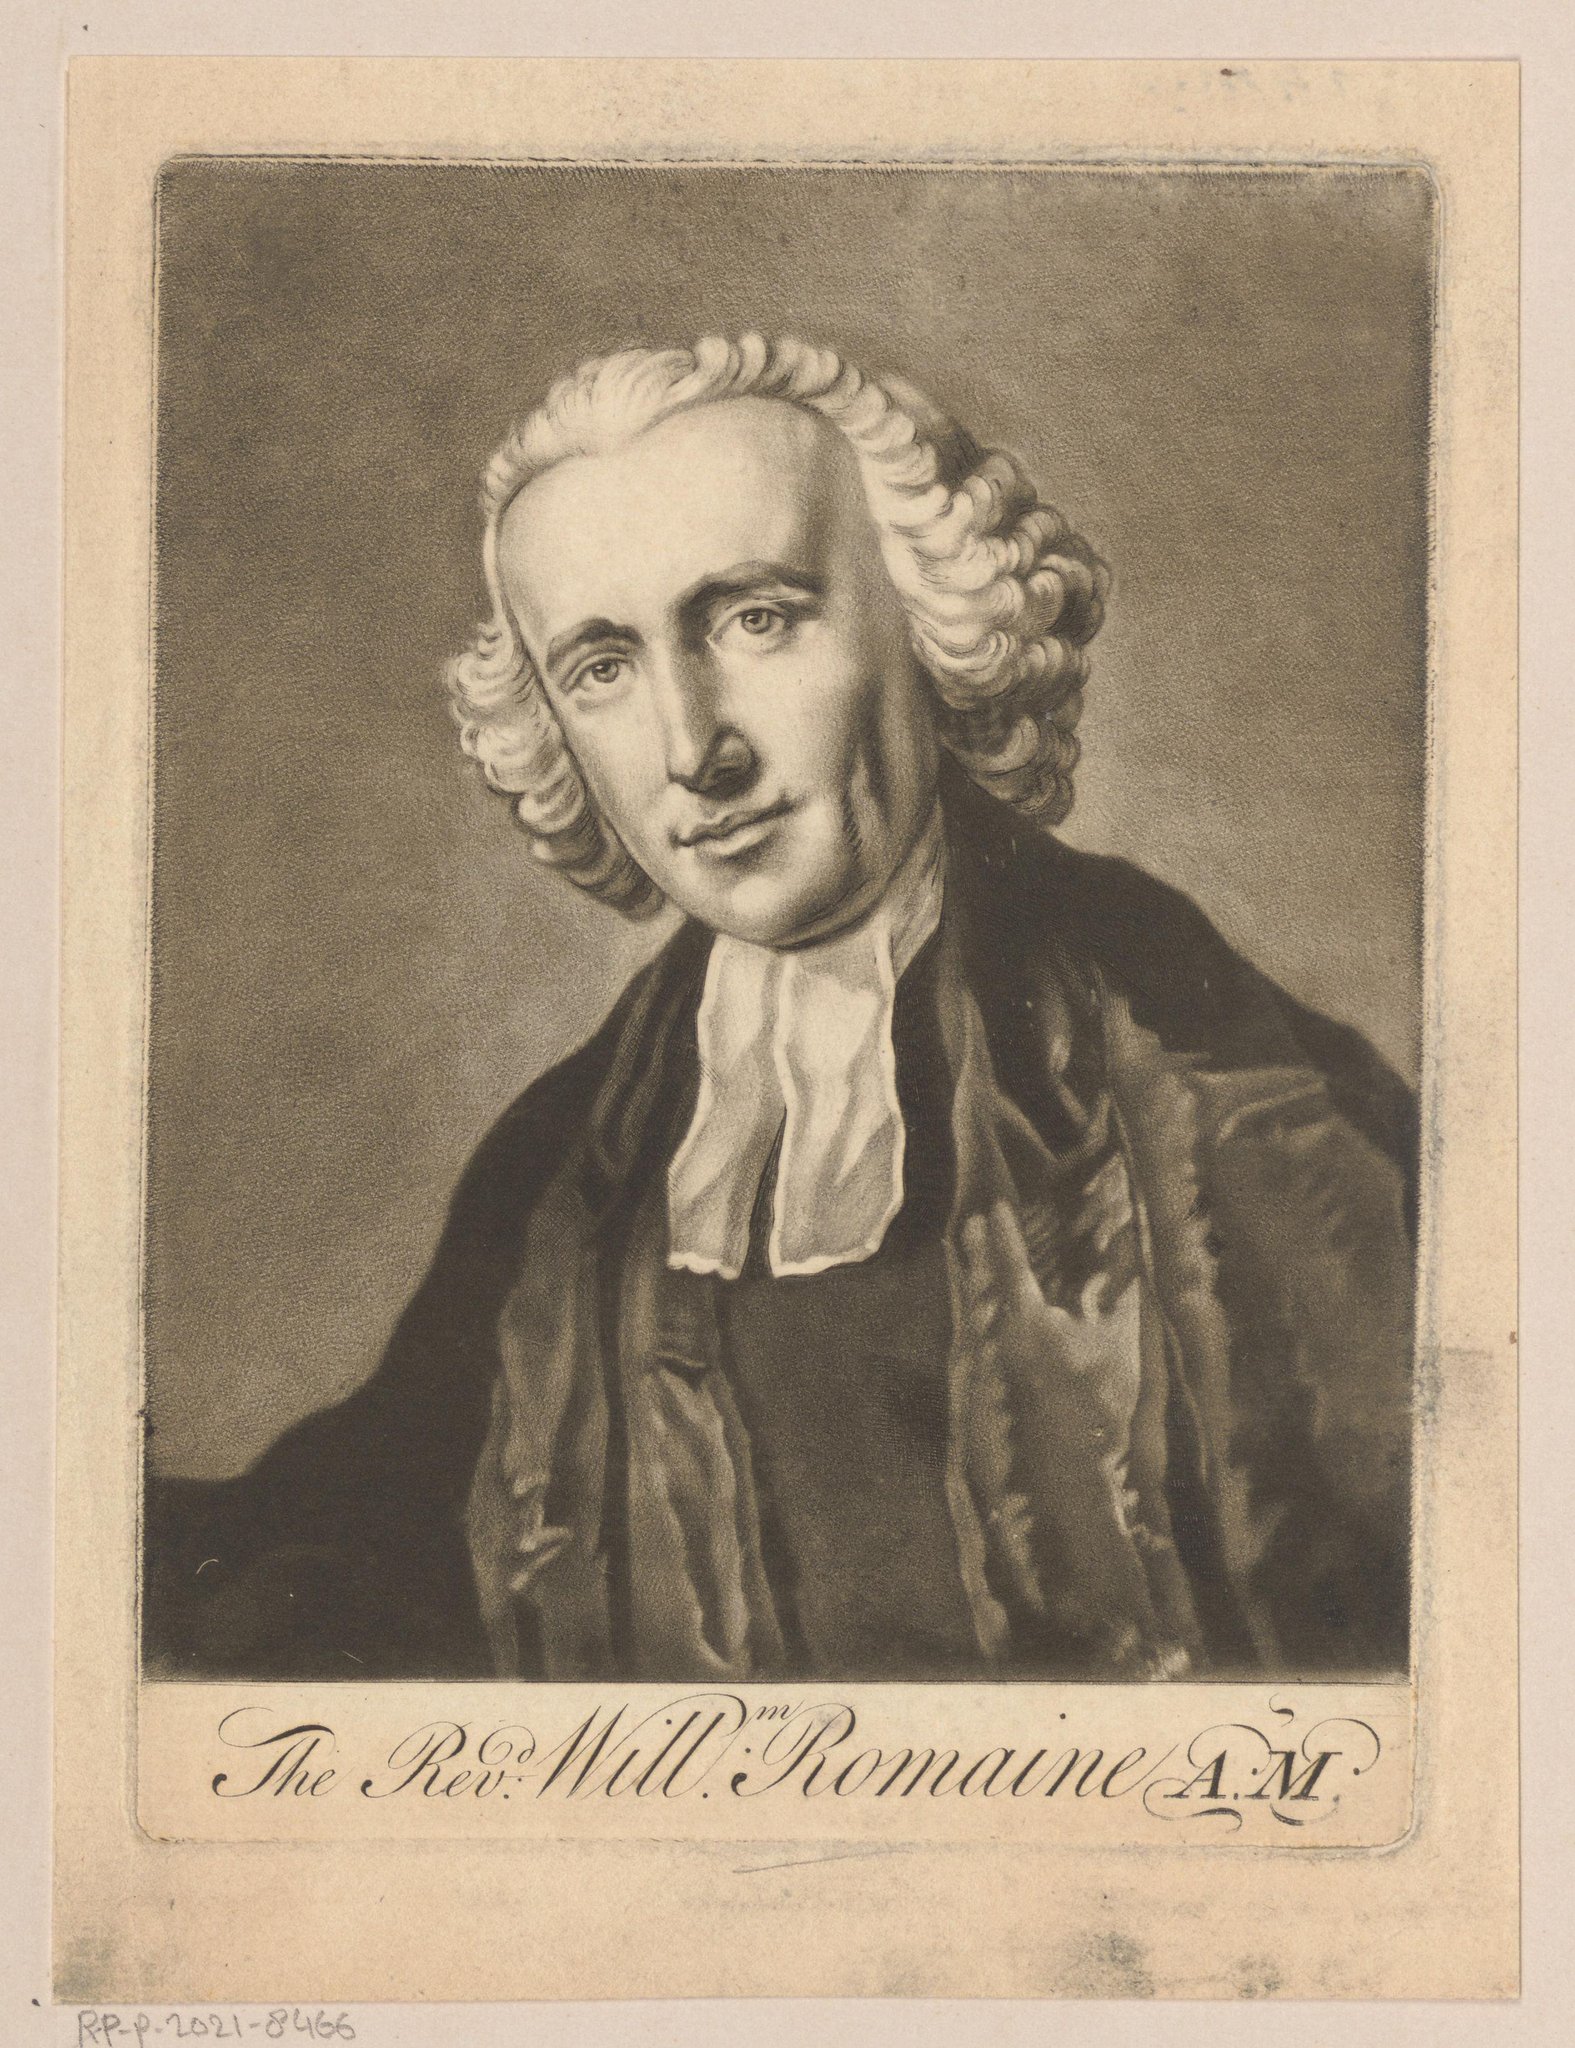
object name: print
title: Portret van William Romaine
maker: Anonymous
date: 1739-1799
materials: paper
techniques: engraving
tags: historical persons